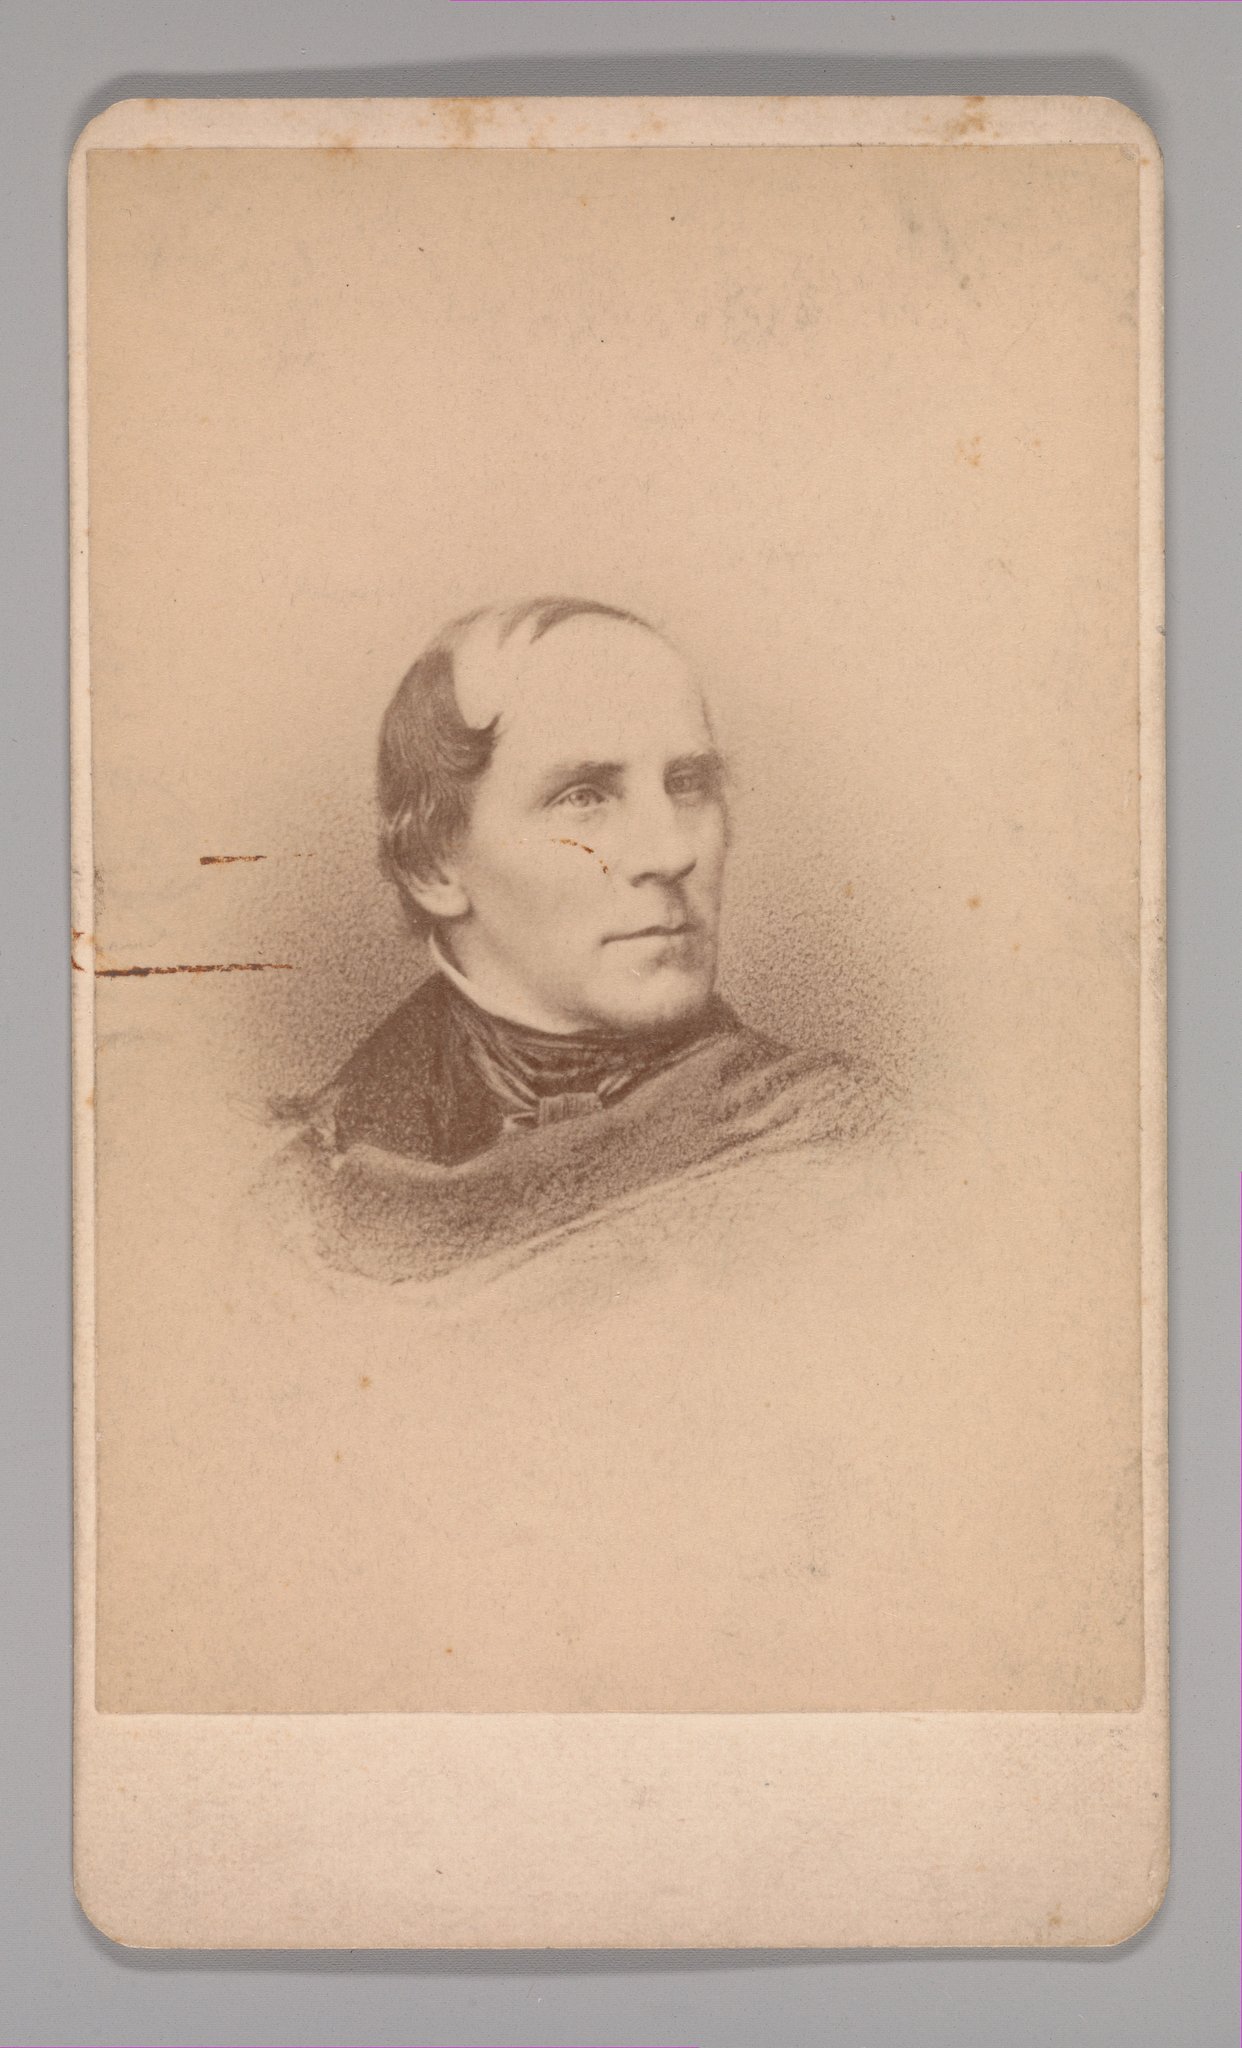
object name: carte de visite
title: [James William Cole]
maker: Anonymous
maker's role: artist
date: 1860-1869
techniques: albumen silver print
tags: men,portraits